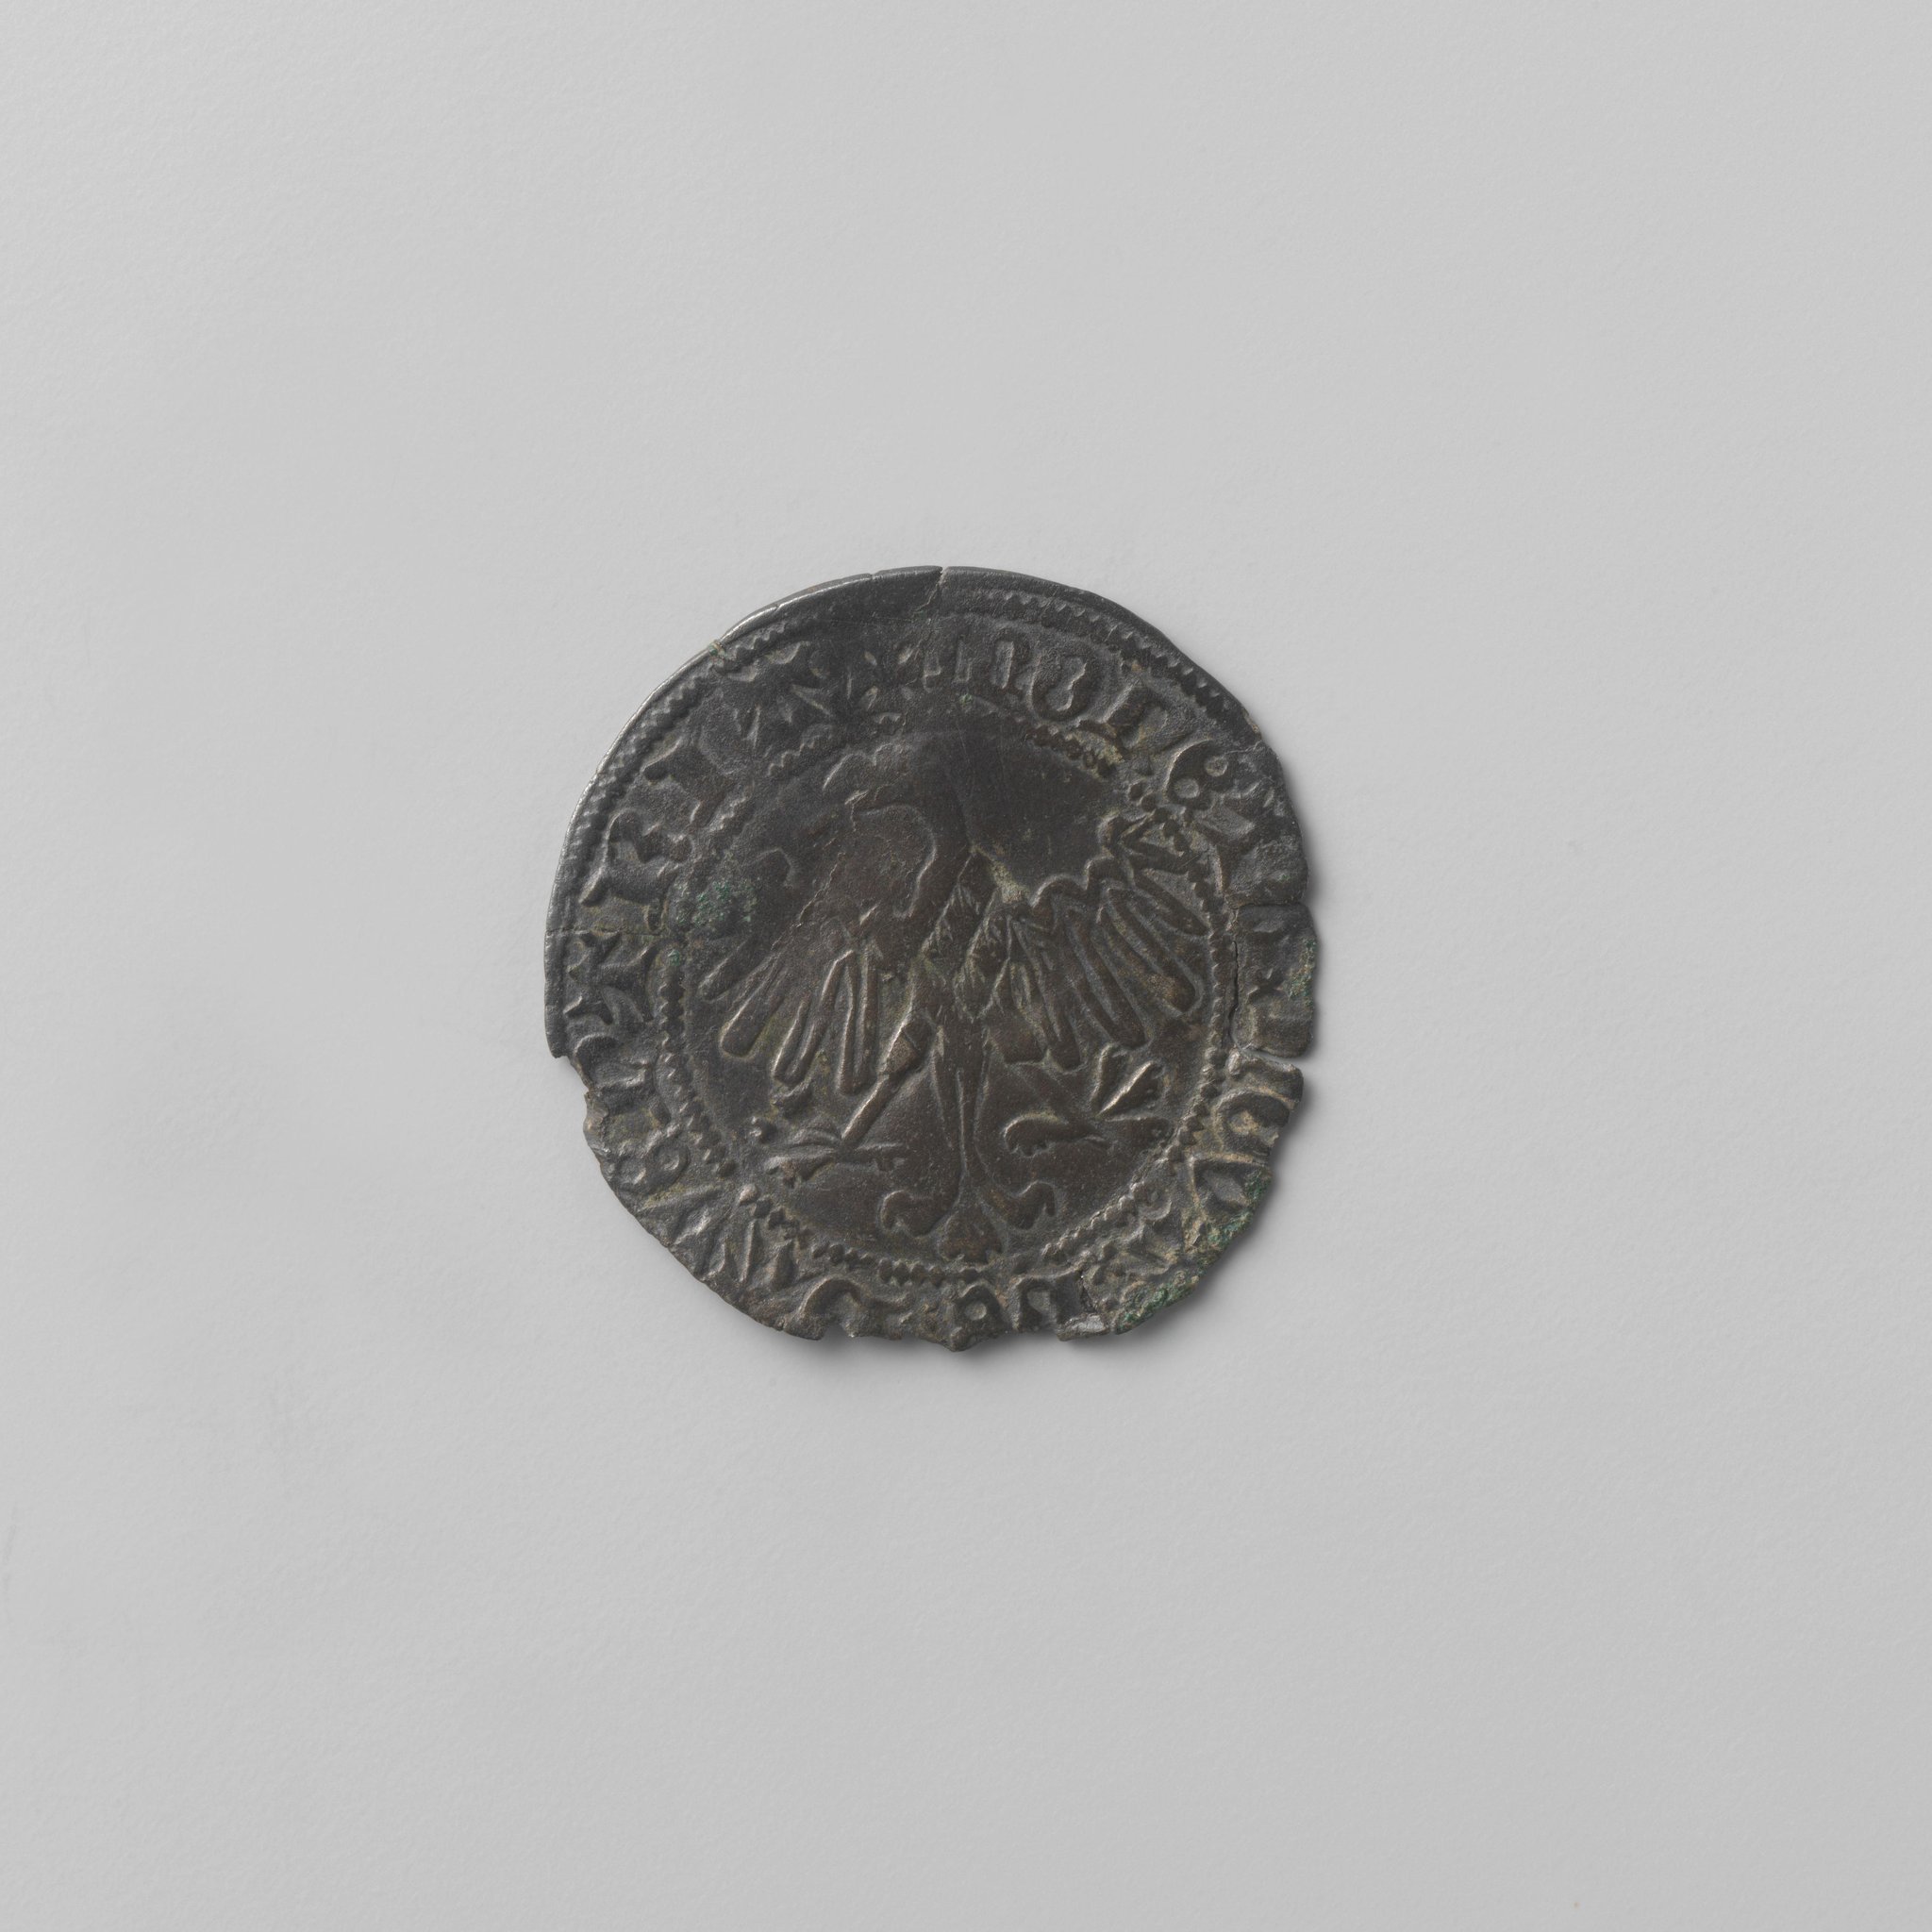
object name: coin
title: Utrecht, Rudolf van Diepholt, groot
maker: rudolf van diepholt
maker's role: bisschop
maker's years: 1390-1455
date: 1433-1455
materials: silver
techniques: striking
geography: deventer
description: Zilveren munt. Voorzijde: wapenschild van Diepholt op lang gevoet kruis. Keerzijde: adelaar.